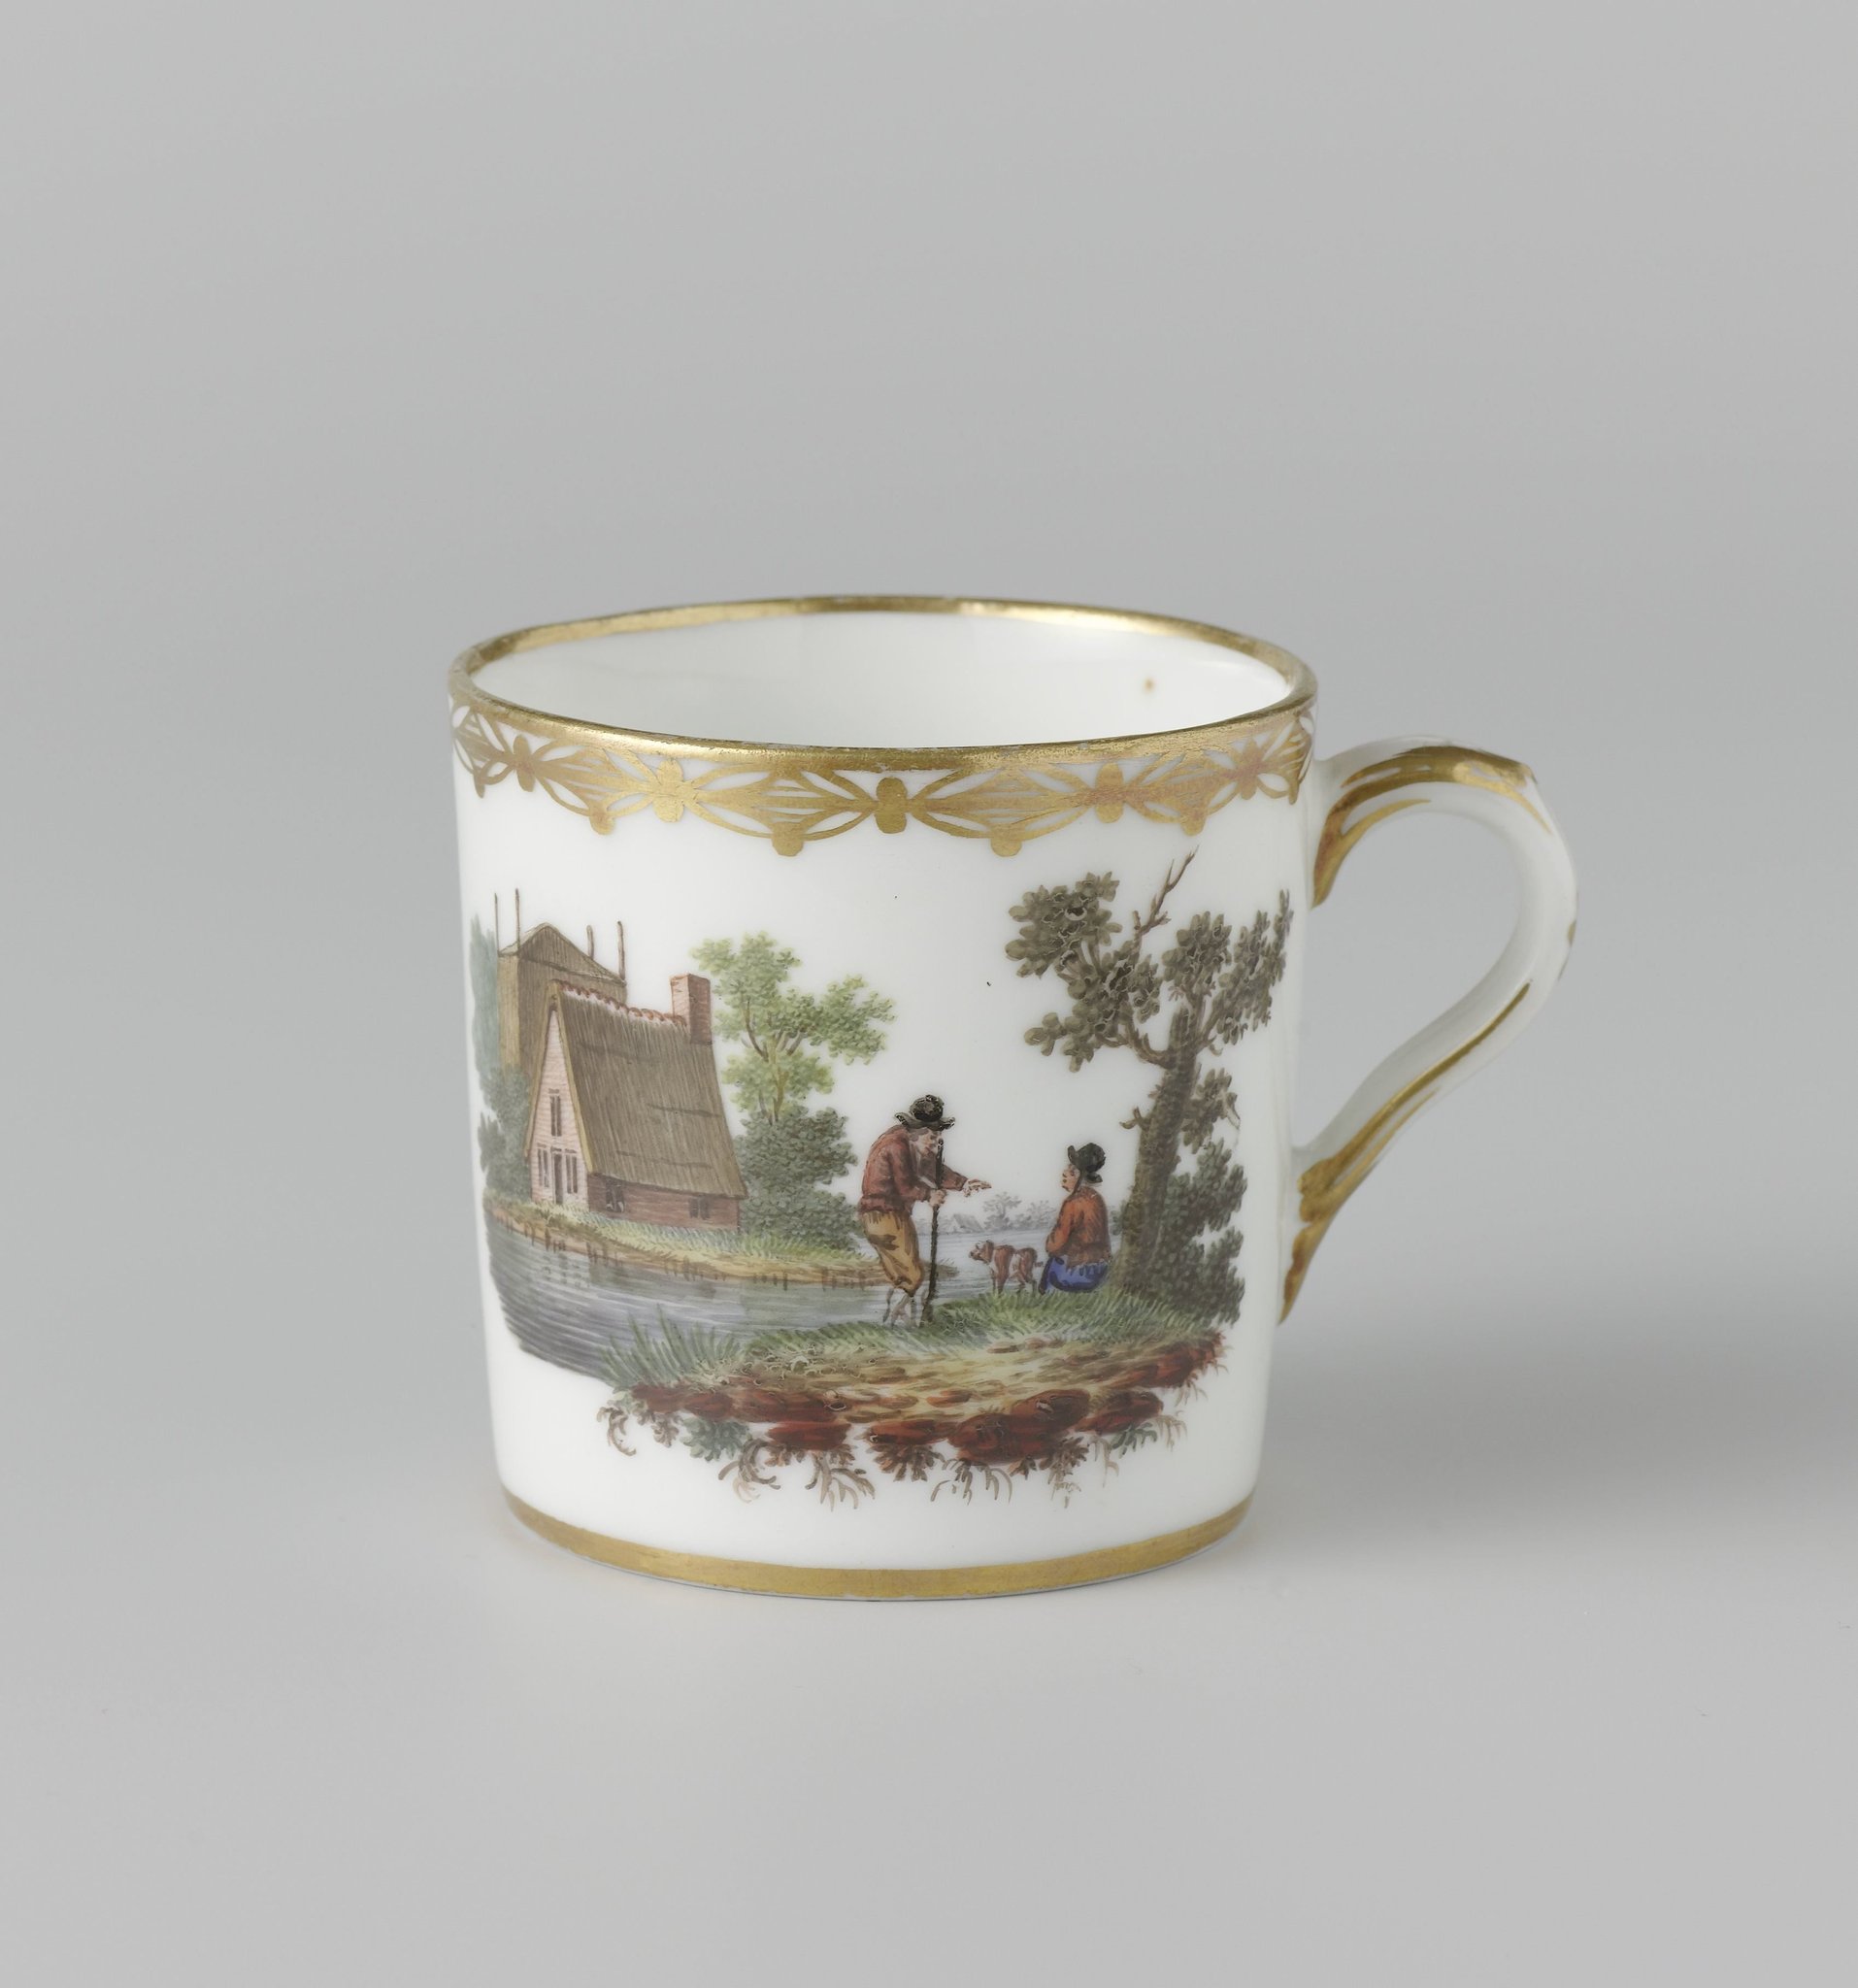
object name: tea service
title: Kop, beschilderd met een landschap met vee en huizen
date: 1809-1814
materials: porcelain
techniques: painted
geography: nieuwer-amstel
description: Kop, beschilderd met landschap met vee en huizen. Deze kop heeft een afwijkend gouden decor. Gemerkt: Amstel in blauw.